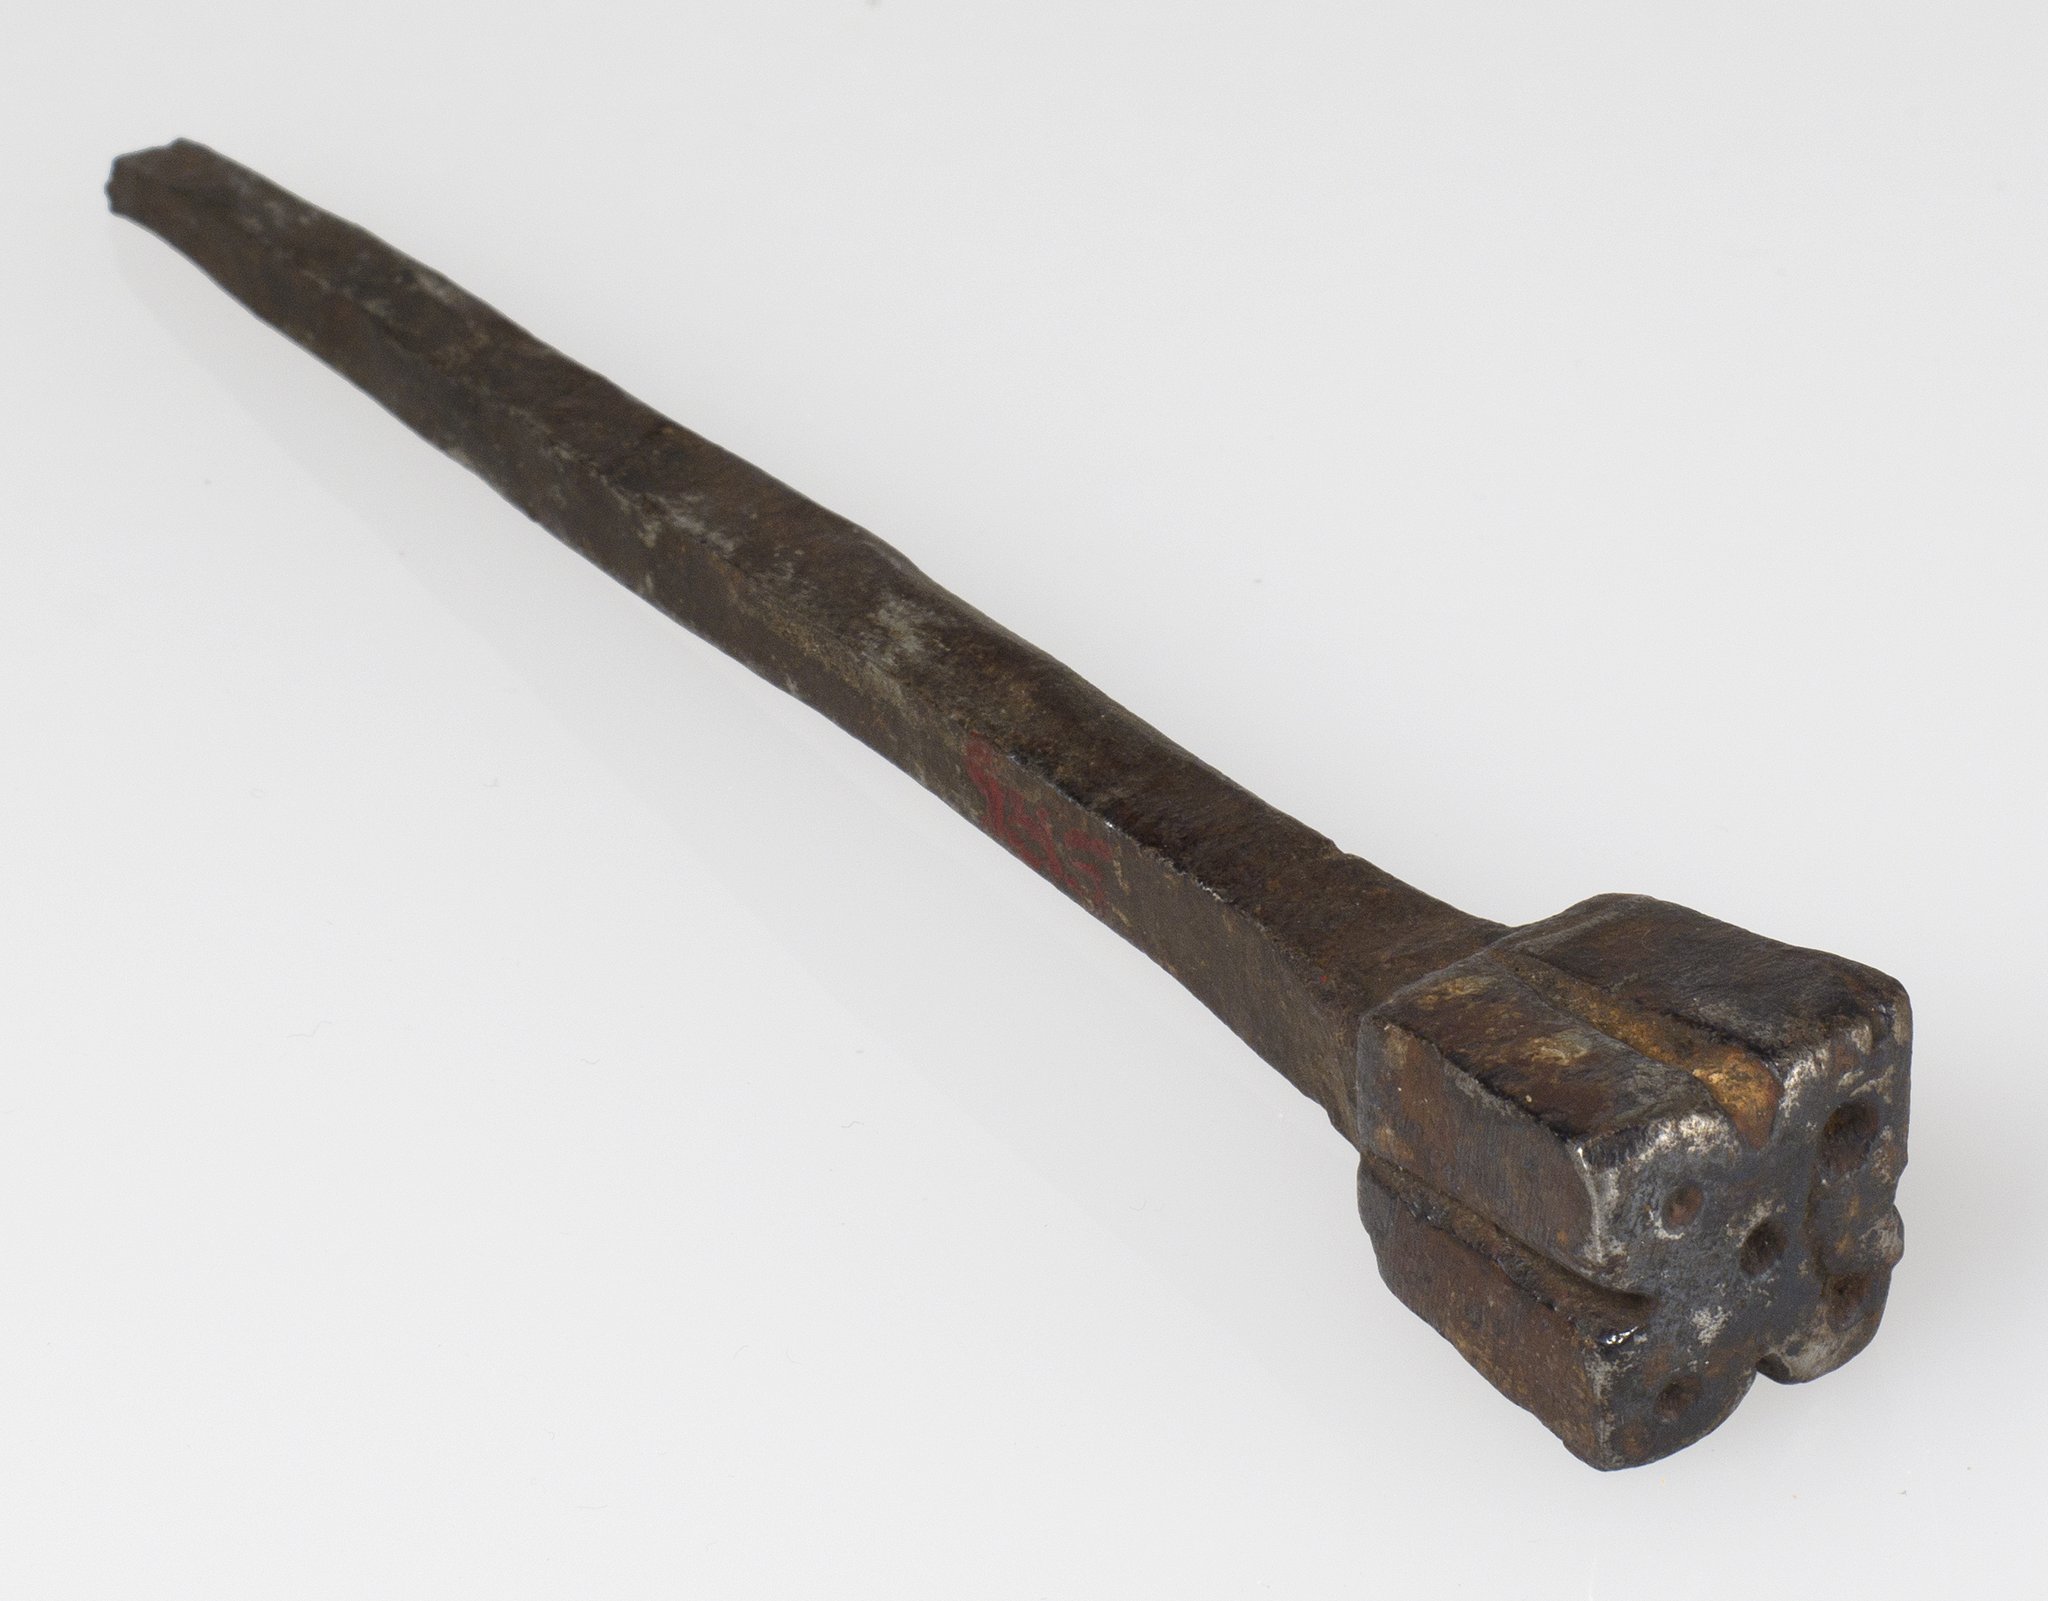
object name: nail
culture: european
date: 1401-1600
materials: iron